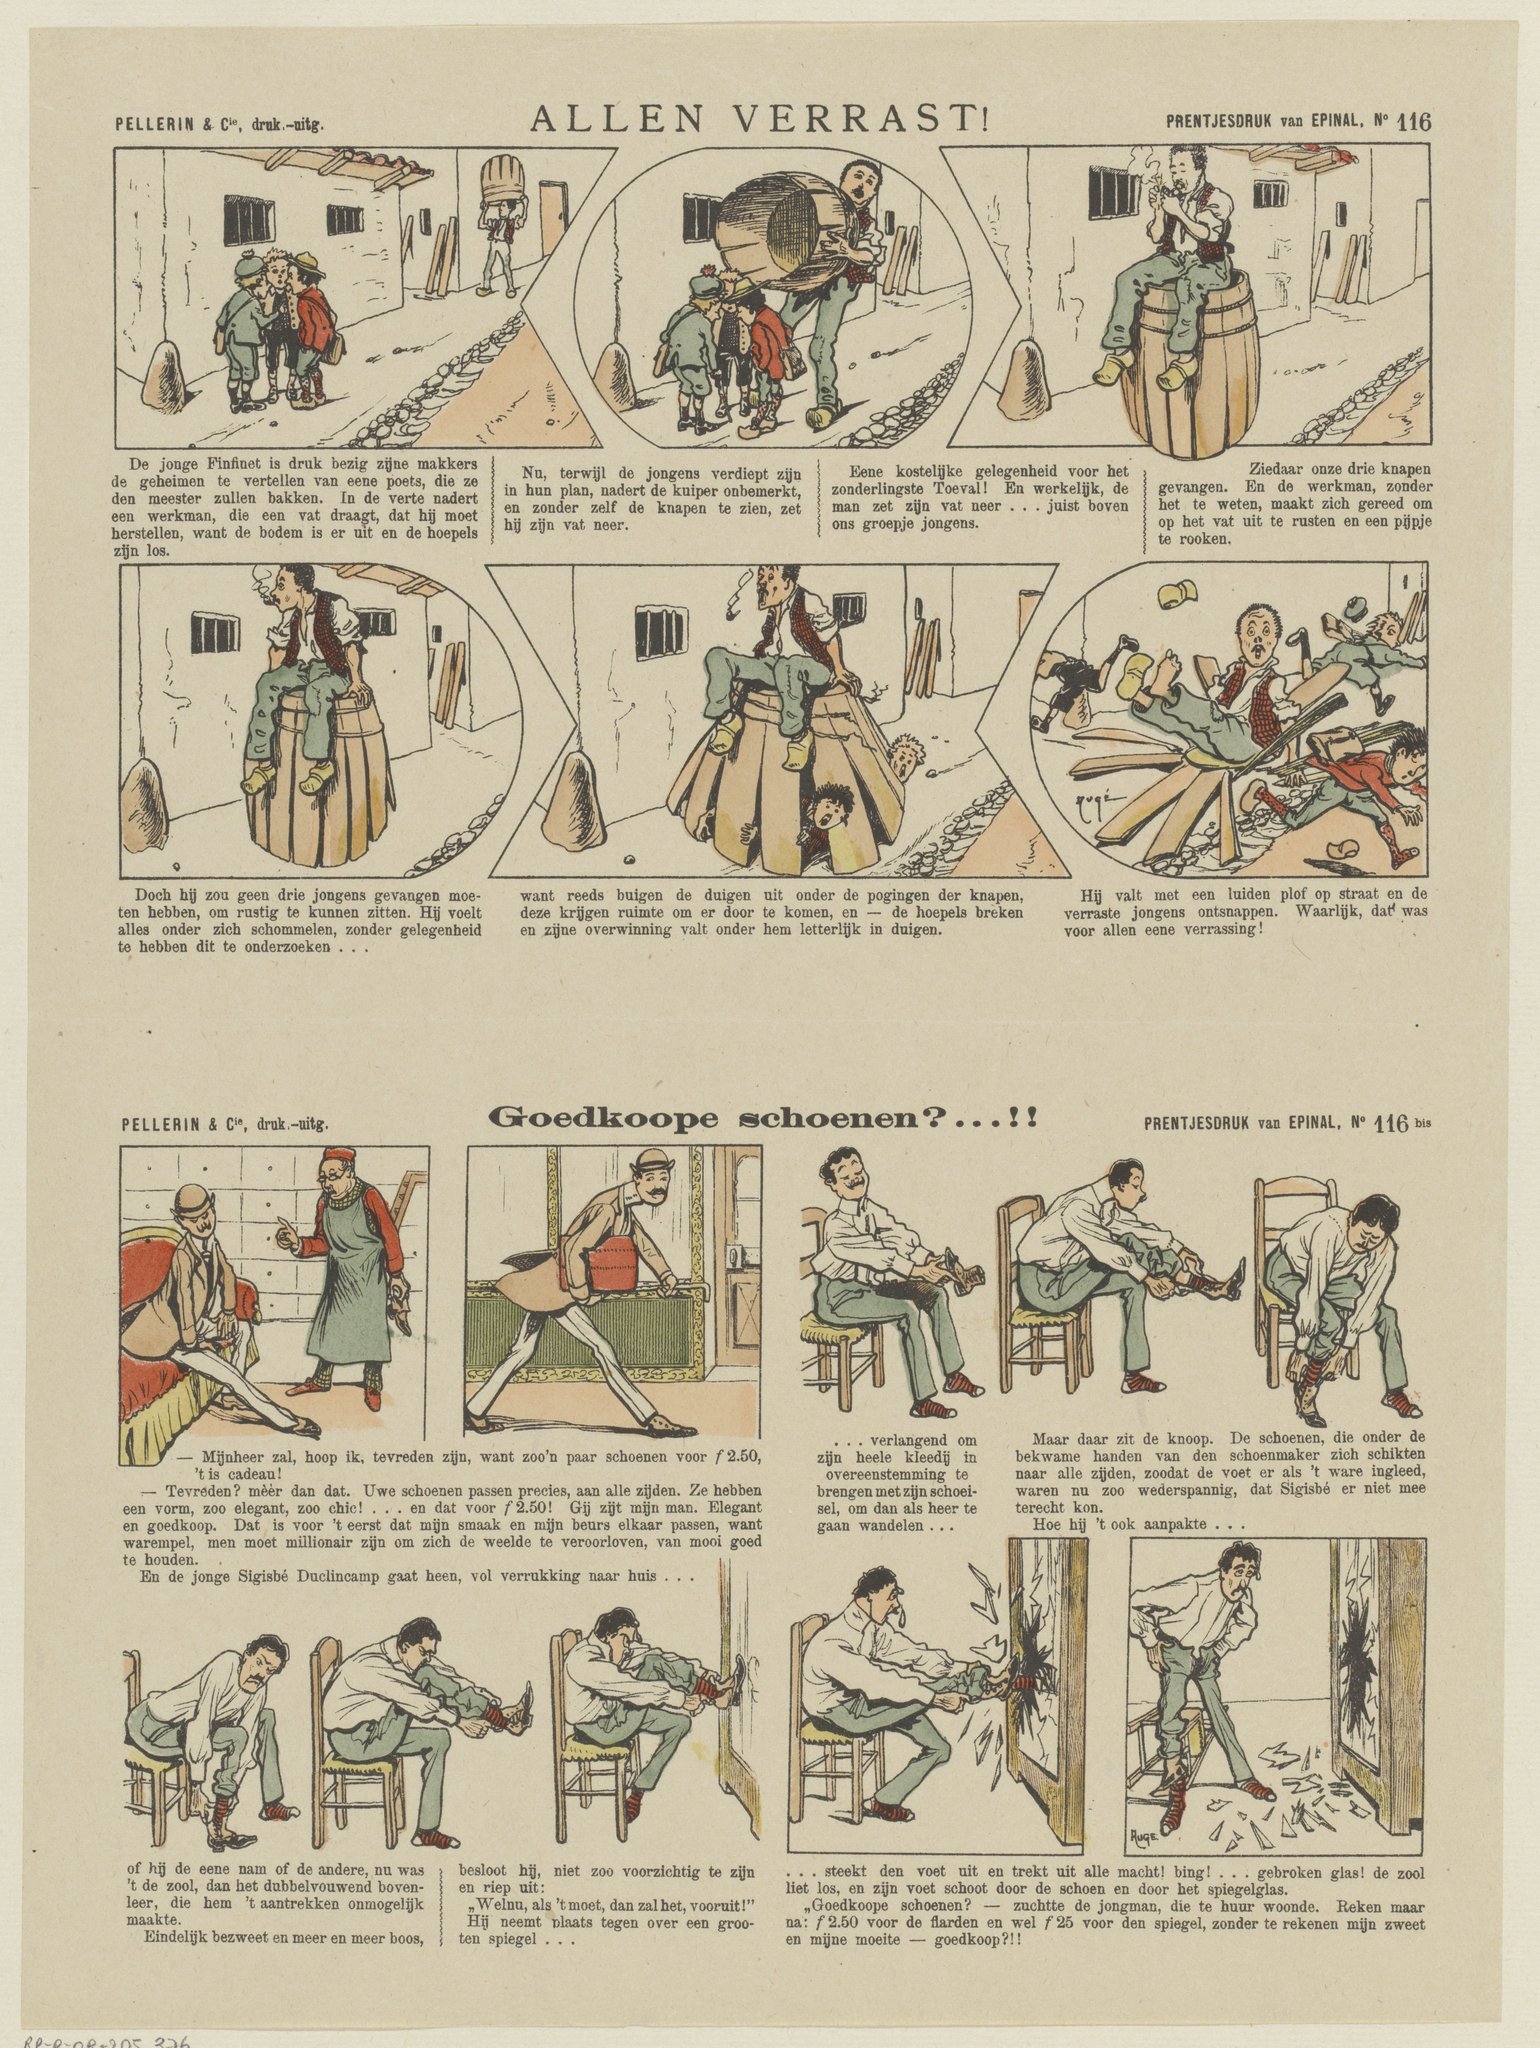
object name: popular print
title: Prentjesdruk van Epinal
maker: augé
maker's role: print maker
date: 1902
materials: paper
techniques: colour, letterpress printing, lithograph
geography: epinal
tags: shoes, sandals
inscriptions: collector's mark: Lugt 2760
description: Blad met 16 voorstellingen. Boven 6 voorstellingen over een kuiper die perongeluk een vat over drie kinderen zet. Onder 10 voorstellingen over een man die goedkope schoenen koopt, maar ze zelf thuis niet meer aankrijgt. Onder elke afbeelding een onderschrift. Genummerd rechtsboven: No 116.